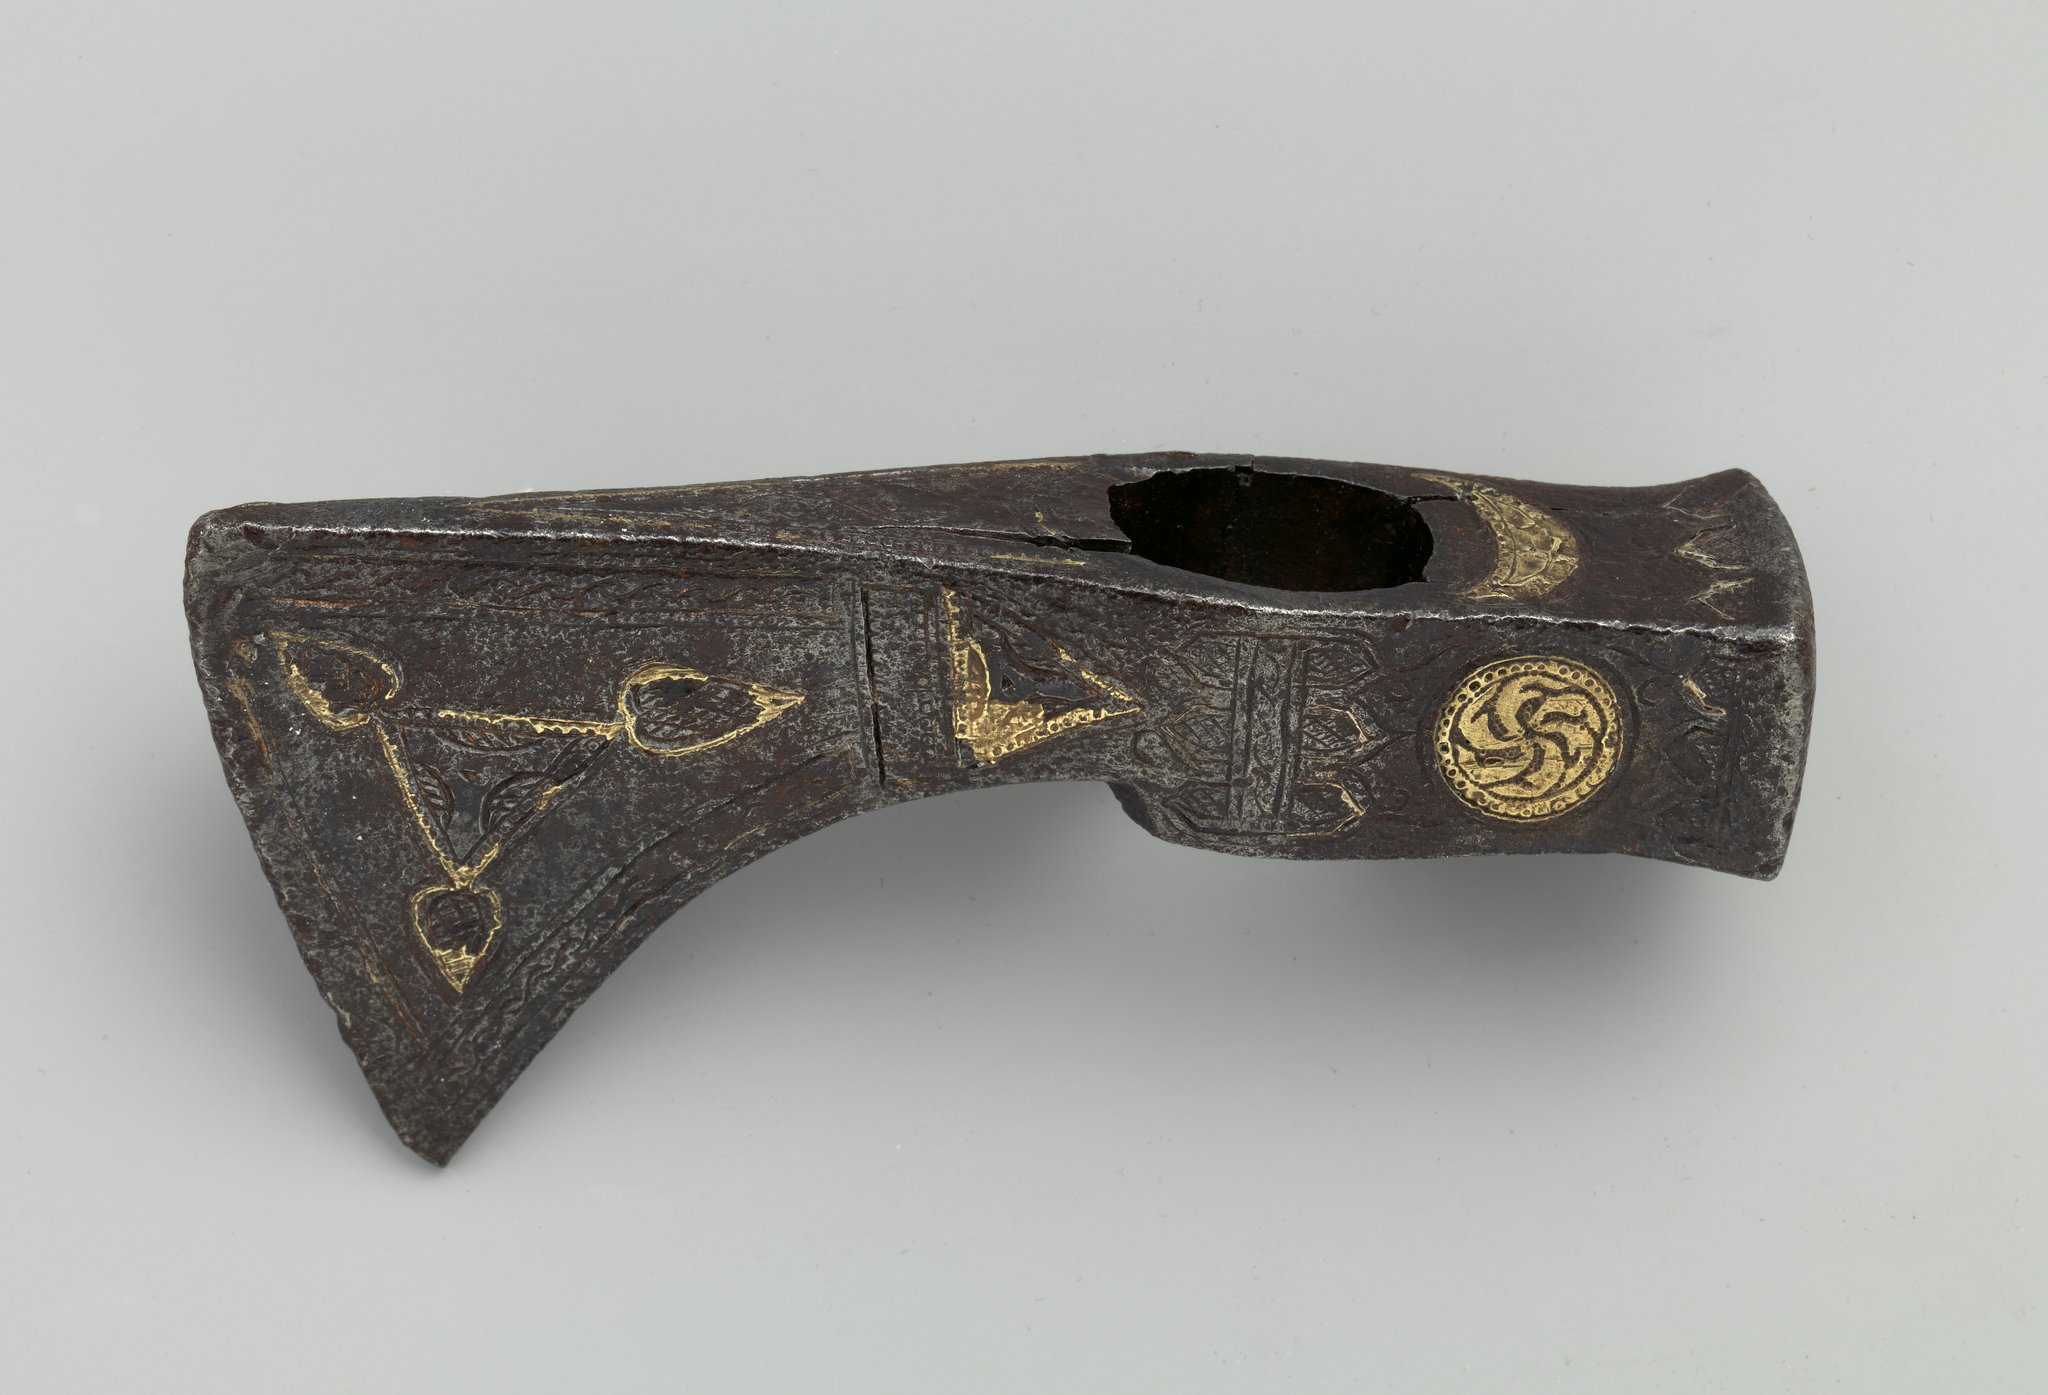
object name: axe head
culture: circassian or tatar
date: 1501-1700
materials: copper alloy, silver, steel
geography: central asia